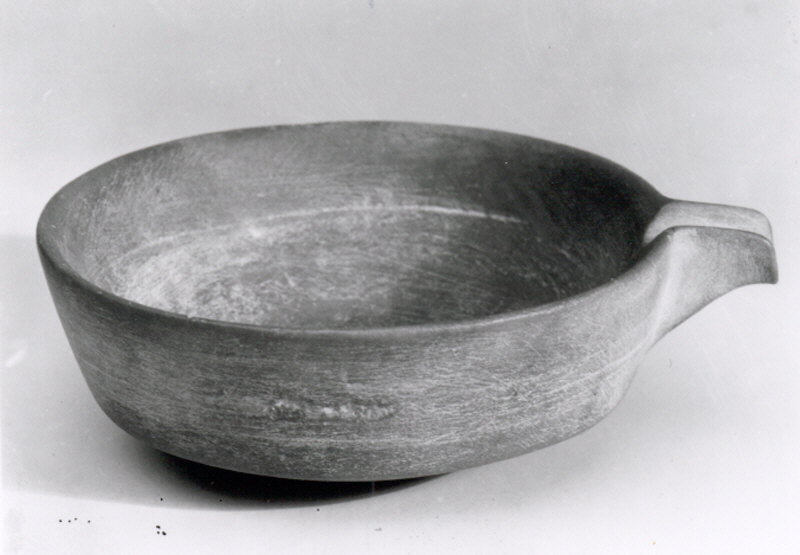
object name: cup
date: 3100-2900 BCE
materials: stone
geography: mesopotamia